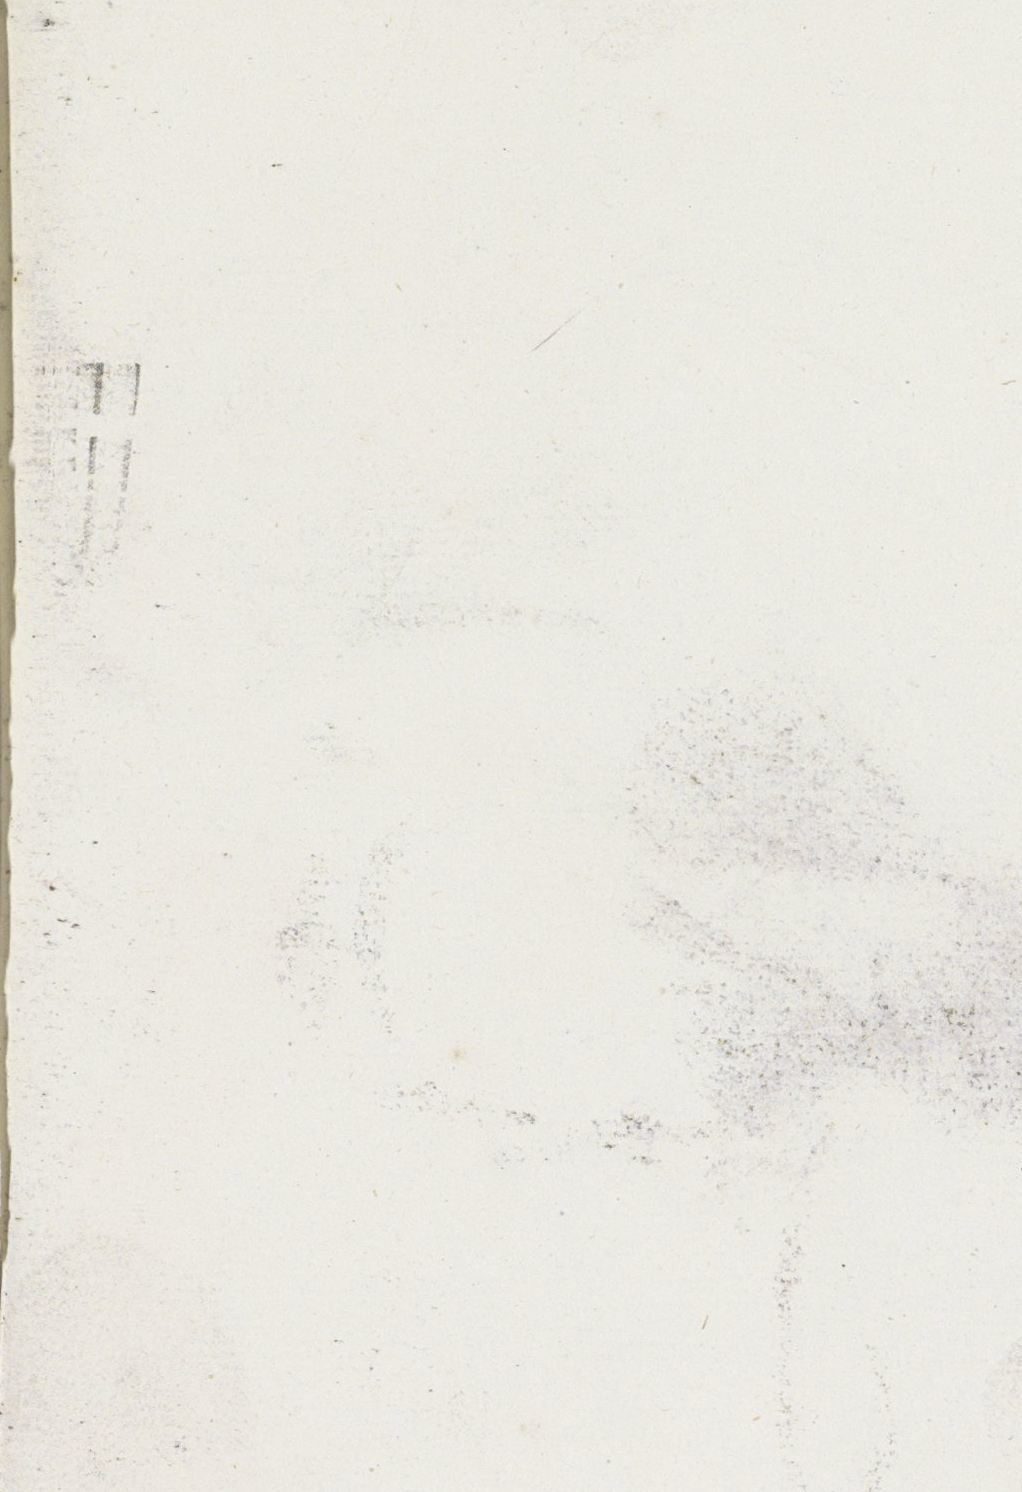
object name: sketchbook leaf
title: Abklatsch van de krijttekening op pagina 31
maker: isaac israels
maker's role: draughtsman, painter, print maker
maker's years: 1865-1934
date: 1875-1934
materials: paper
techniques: printmaking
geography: the hague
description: Pagina 32 uit schetsboek XLIV met 43 pagina's.